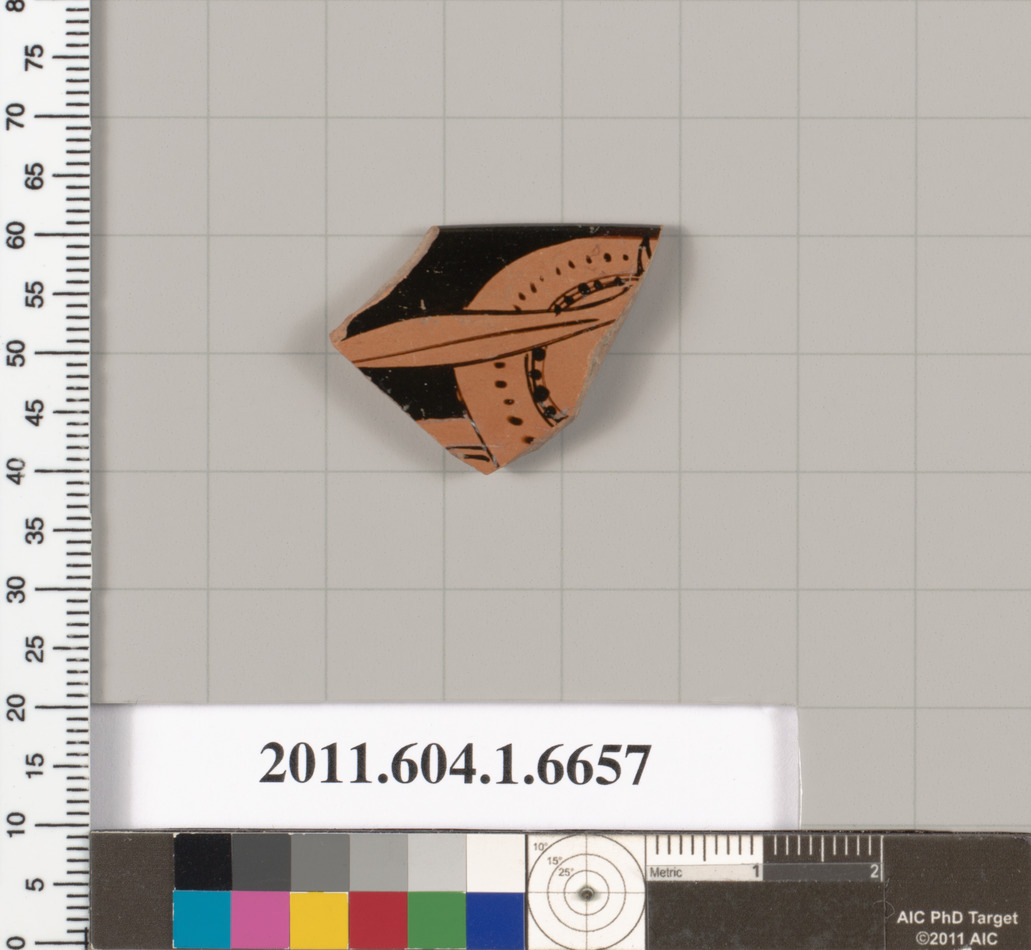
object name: kylix fragment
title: Terracotta rim fragment of a kylix (drinking cup)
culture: greek, attic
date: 490-470 BCE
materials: terracotta